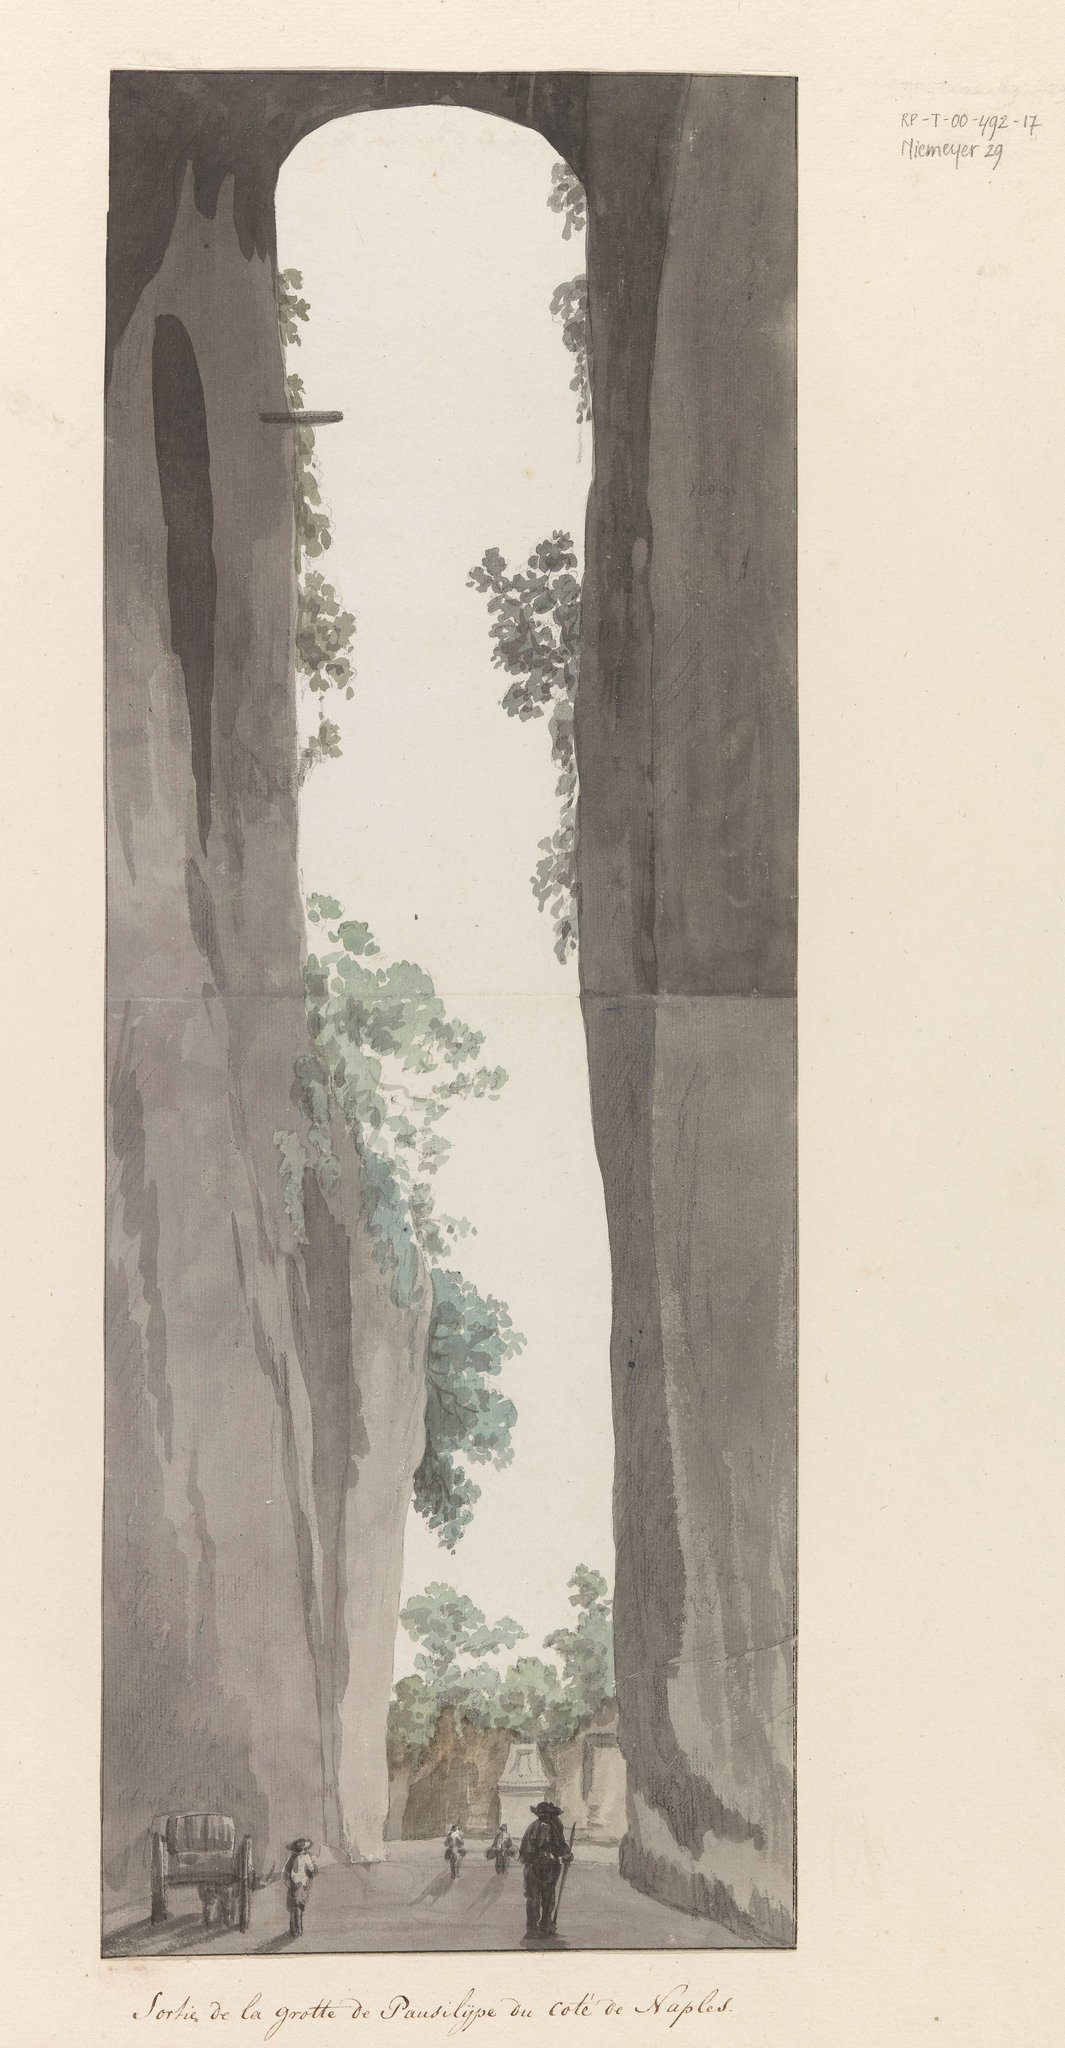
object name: drawing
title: Sortie de la grotte du Pausilype du côté de Naples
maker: louis ducros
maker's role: draughtsman, print maker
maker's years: 1748-1810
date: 1778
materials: chalk, paper, watercolor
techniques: brush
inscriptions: number: ‘No 18 Sortie de la grotte du Pausilype du côté de Naples’